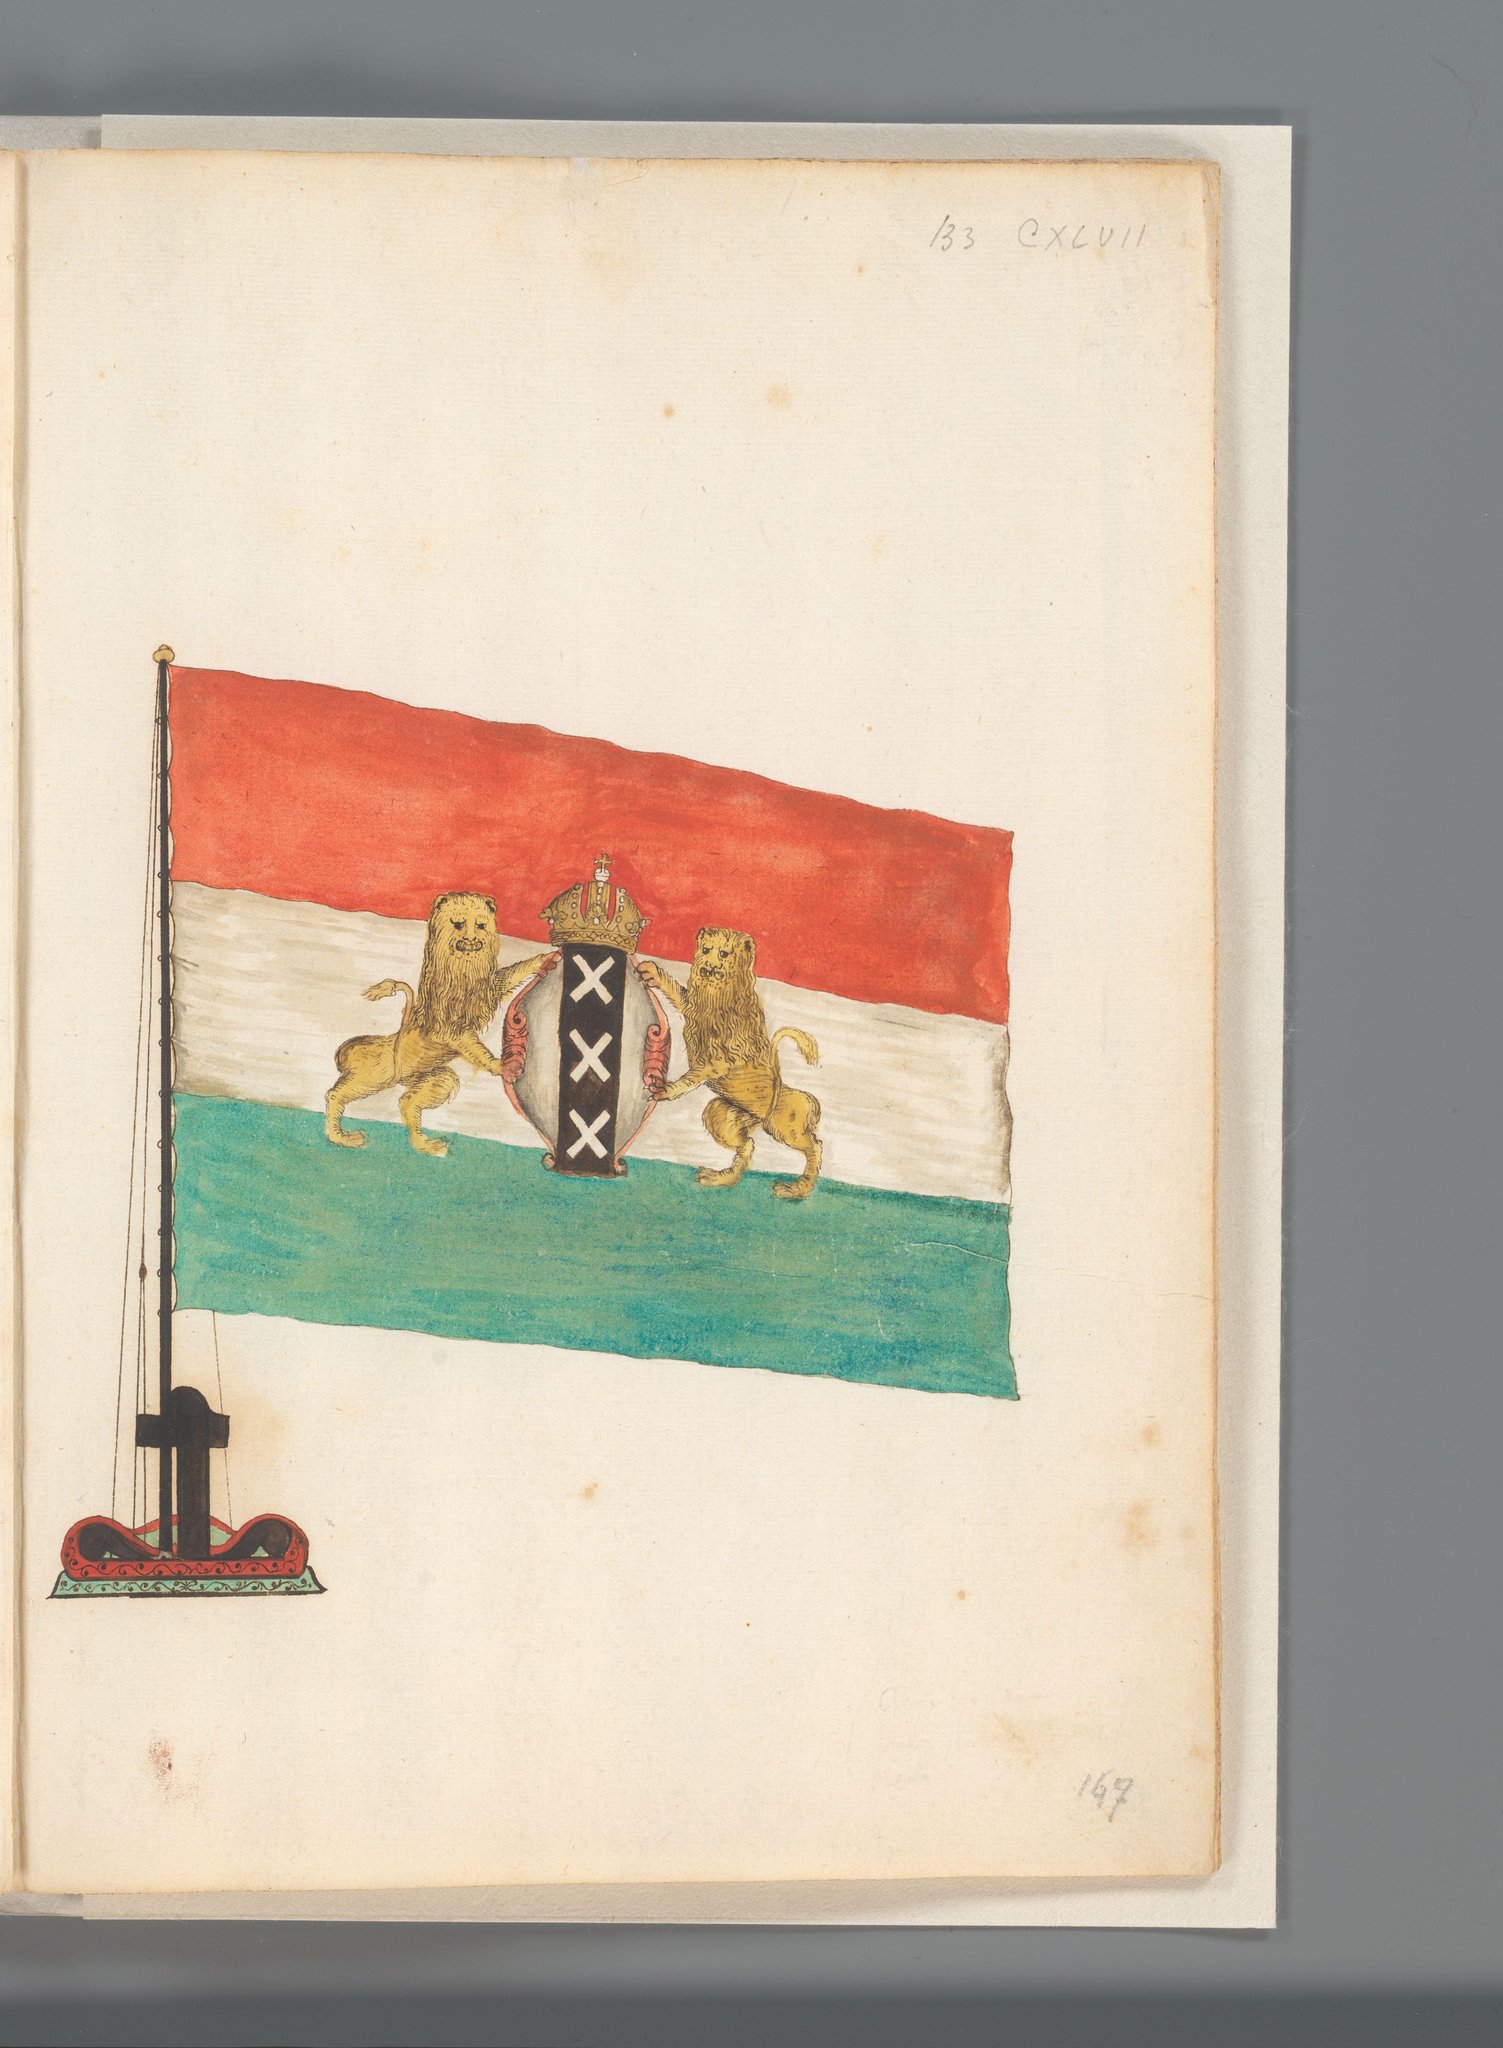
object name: drawing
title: Vlag van Amsterdam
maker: Anonymous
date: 1667-1670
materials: ink, paper, watercolor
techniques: pen, striking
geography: france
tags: flag, colours (as symbol of the state, etc.), amsterdam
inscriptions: number: ‘133 / CXLVII / 147’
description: Vlag van Amsterdam. Vlag met het wapen van de stad Amsterdam over drie horizontale banen in rood, wit en blauw. Vlag op vlaggensteng en mastvoet. Afgebeeld op folio 74r. Onderdeel van een vlaggenboek met vlaggen uit Europa, Noord-Afrika, Nabije en Verre Oosten.